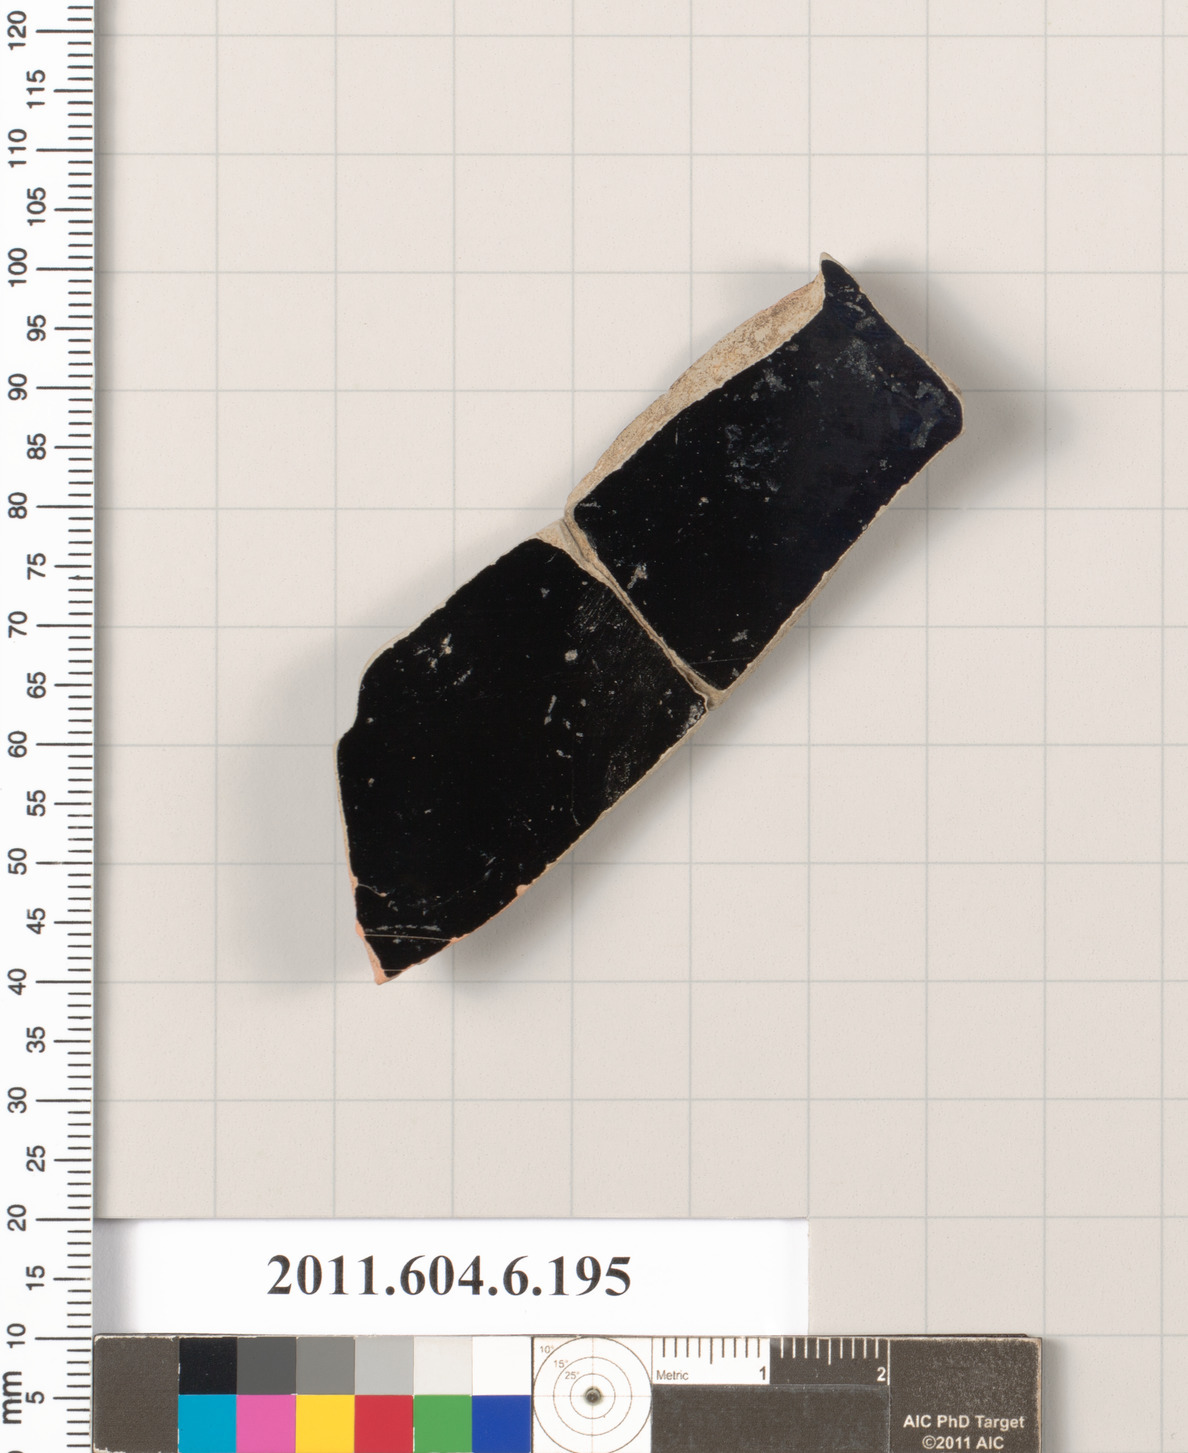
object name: skyphos fragment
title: Terracotta fragment of a skyphos (deep drinking cup)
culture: greek, attic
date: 500-401 BCE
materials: terracotta